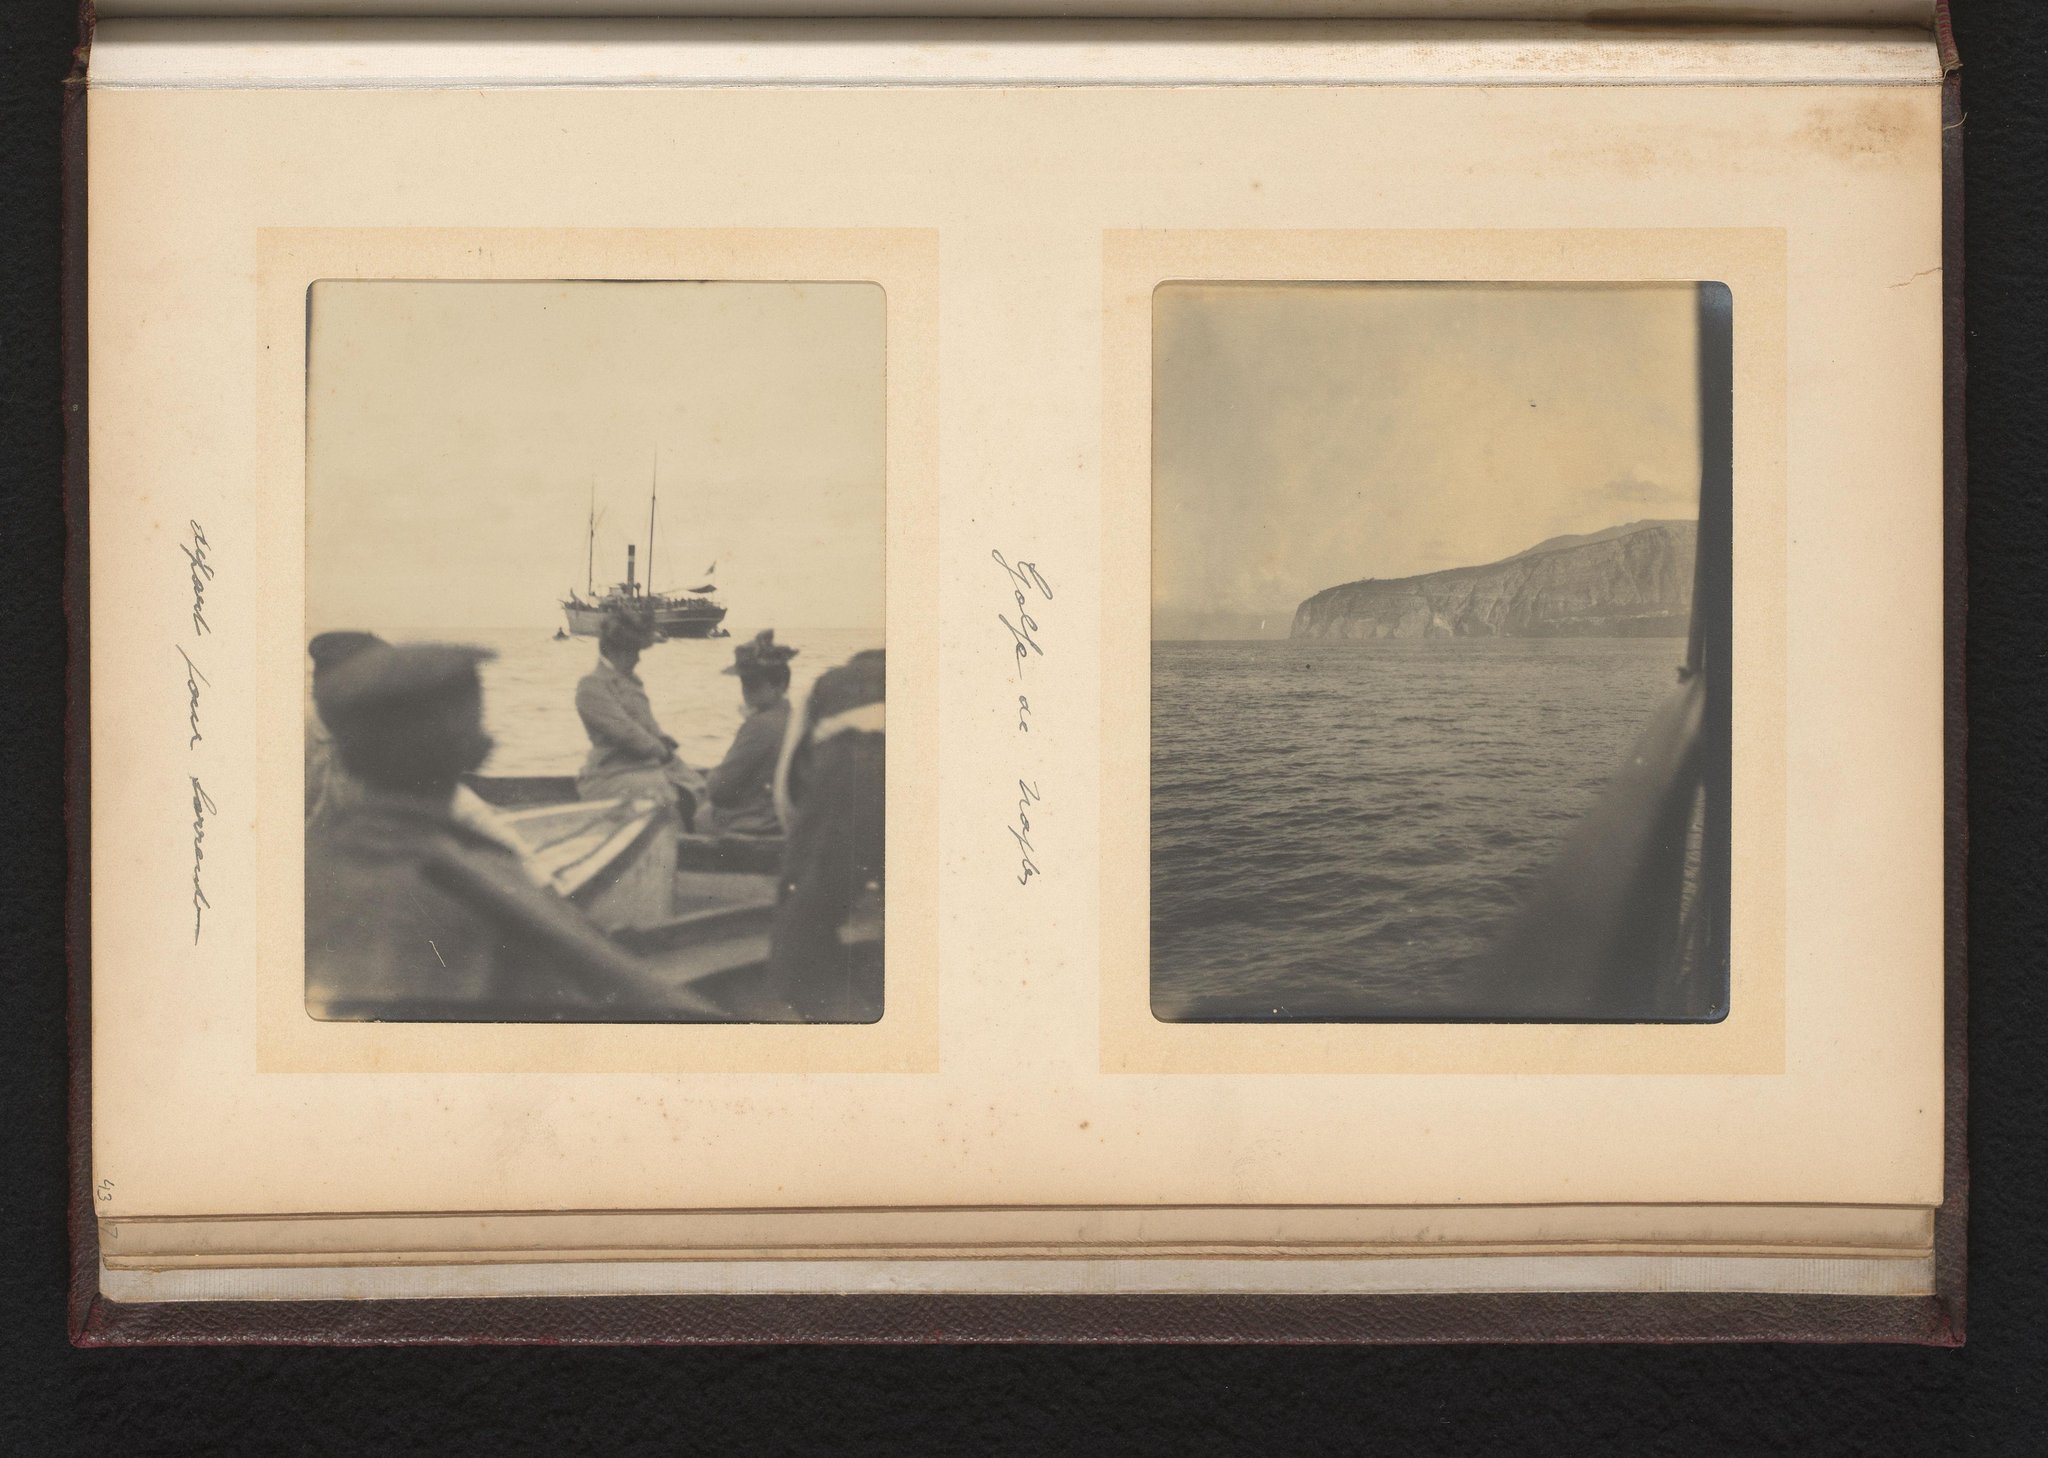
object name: photograph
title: Golf van Napels en onderweg naar Sorrento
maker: Anonymous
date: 1895-1905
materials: cardboard, photographic support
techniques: gelatin silver print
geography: naples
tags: tourism, passengers ~ ship, naples, sorrento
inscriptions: inscription: ‘Golfe de Naples / depart pour Sorrento’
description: Albumblad met twee foto's in Napels. Onderdeel van een fotoalbum van een reis door Italië, ca. 1900.